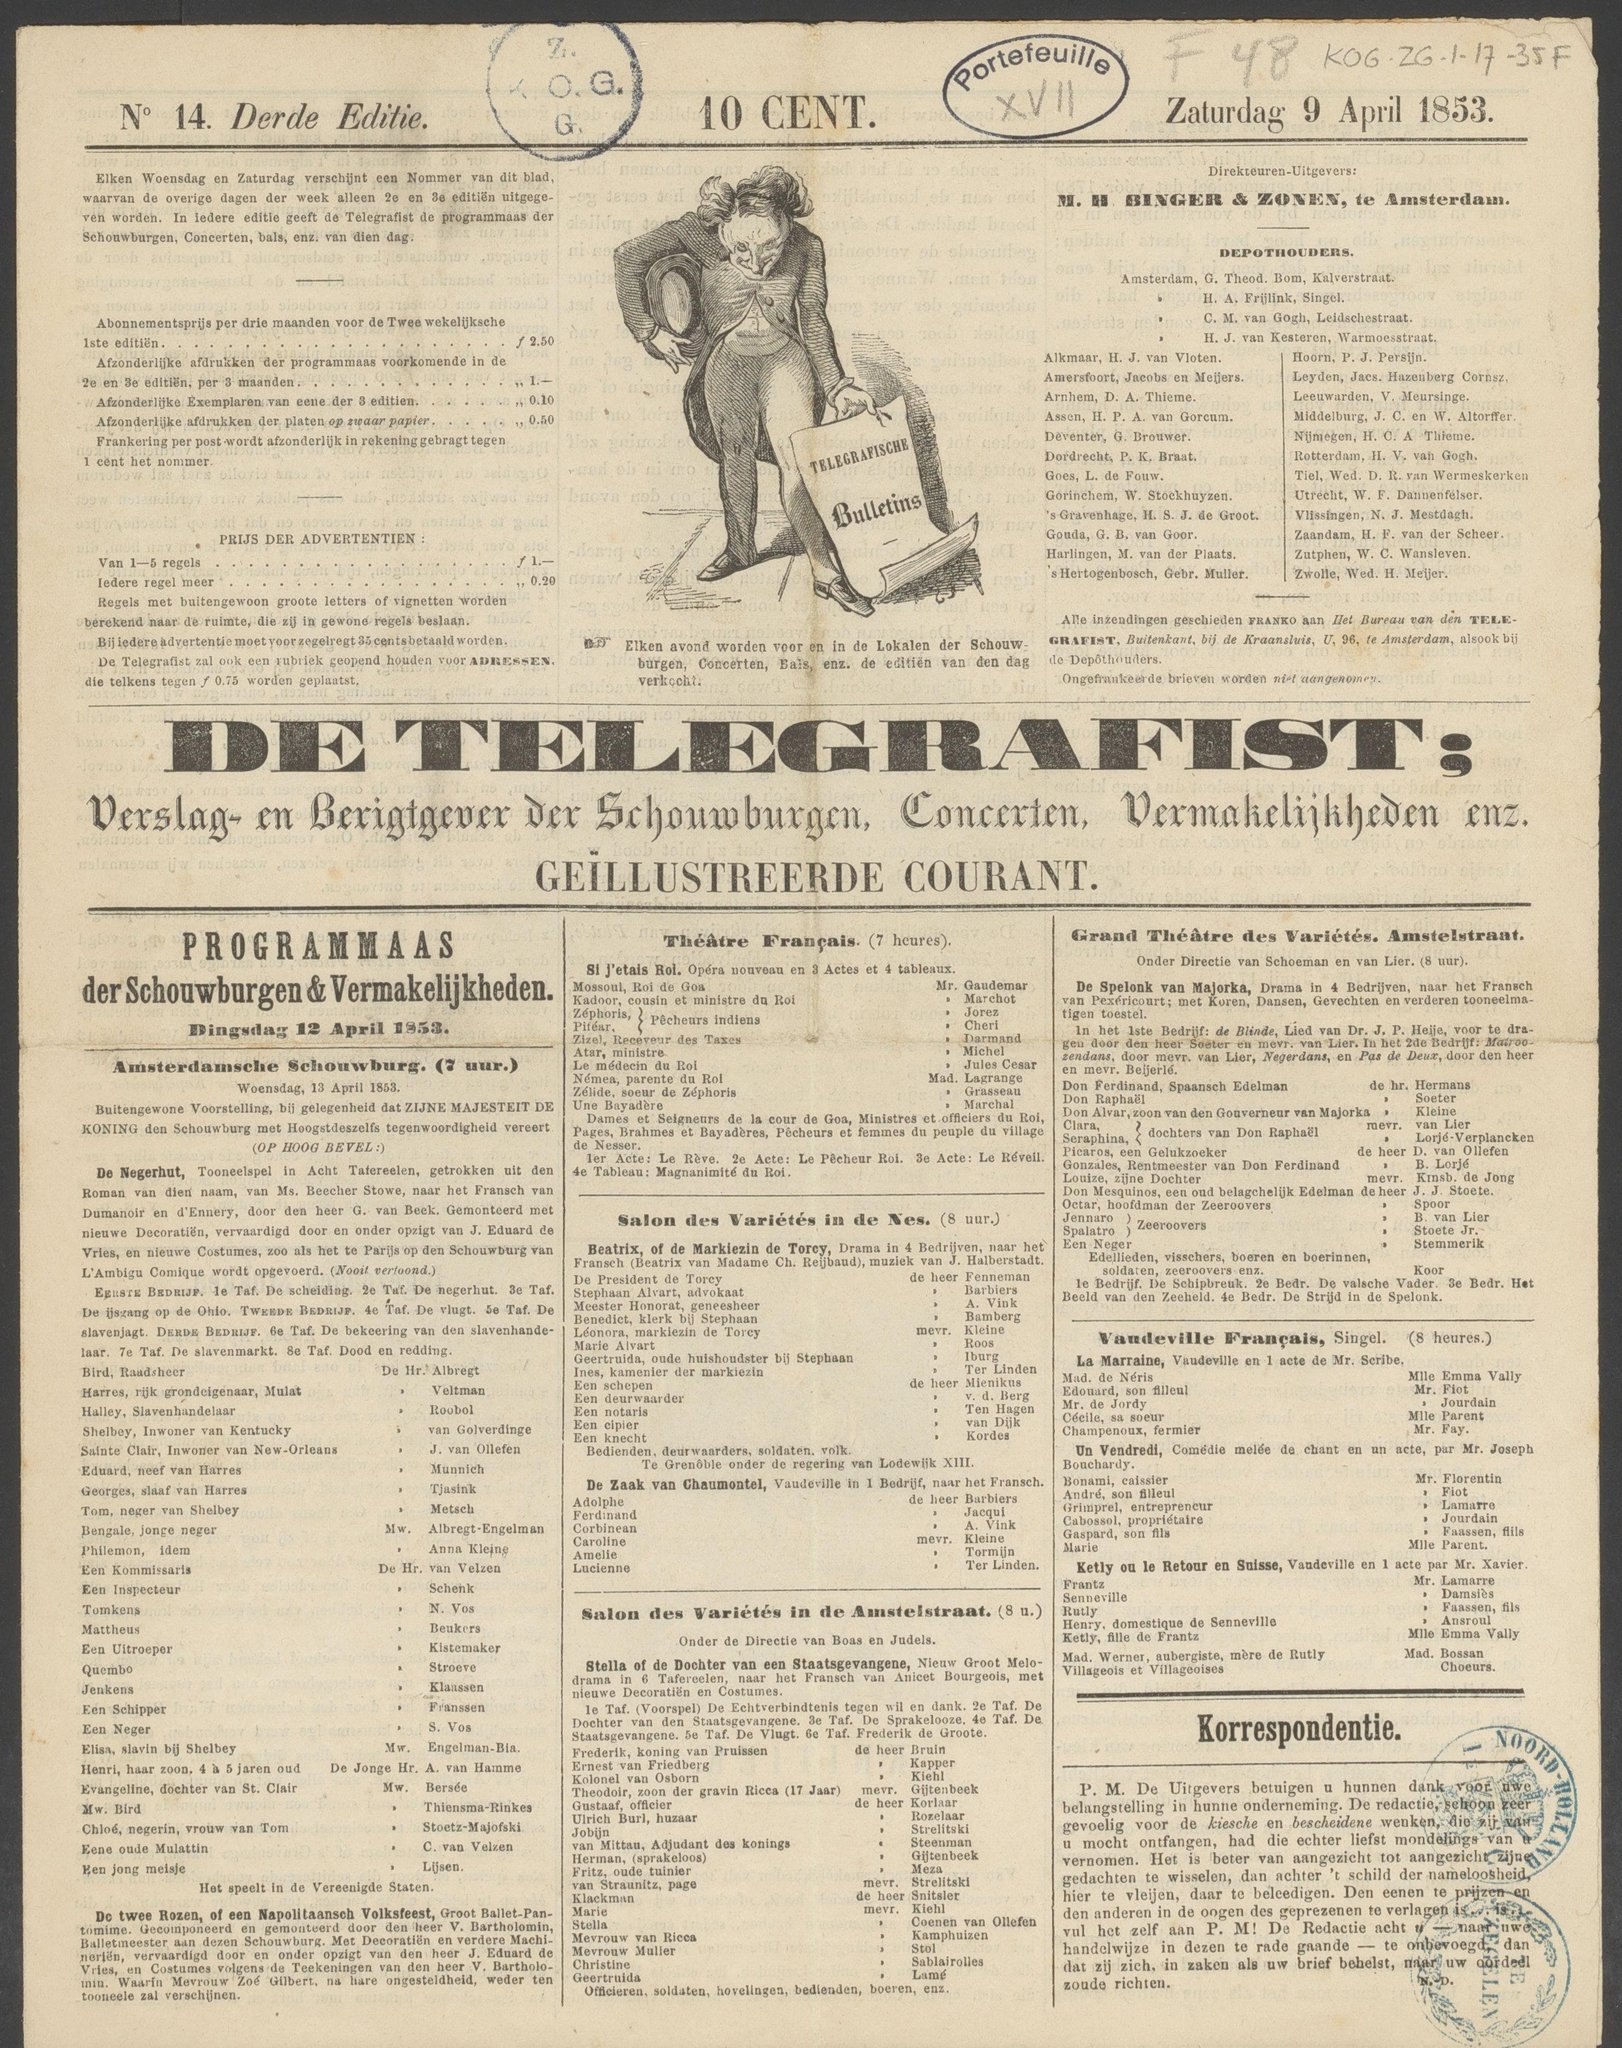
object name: newspaper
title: De Telegrafist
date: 1853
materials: paper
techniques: letterpress printing, lithograph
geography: amsterdam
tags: slave-trade, theatre, theatrical performance, historical persons, portrait of a writer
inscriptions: collector's mark: Lugt 1641, stamp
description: De Telegrafist, krant voor schouwburgen, concerten en vermaak. Linksboven genummerd: No 13. Tweede Editie. Met een portret van Leopold Friedrich Günther Goeckingk. Onderwerpsrubrieken binnen de Atlas Zeden en Gewoonten: Tooneel, Toneelprogramma’s.